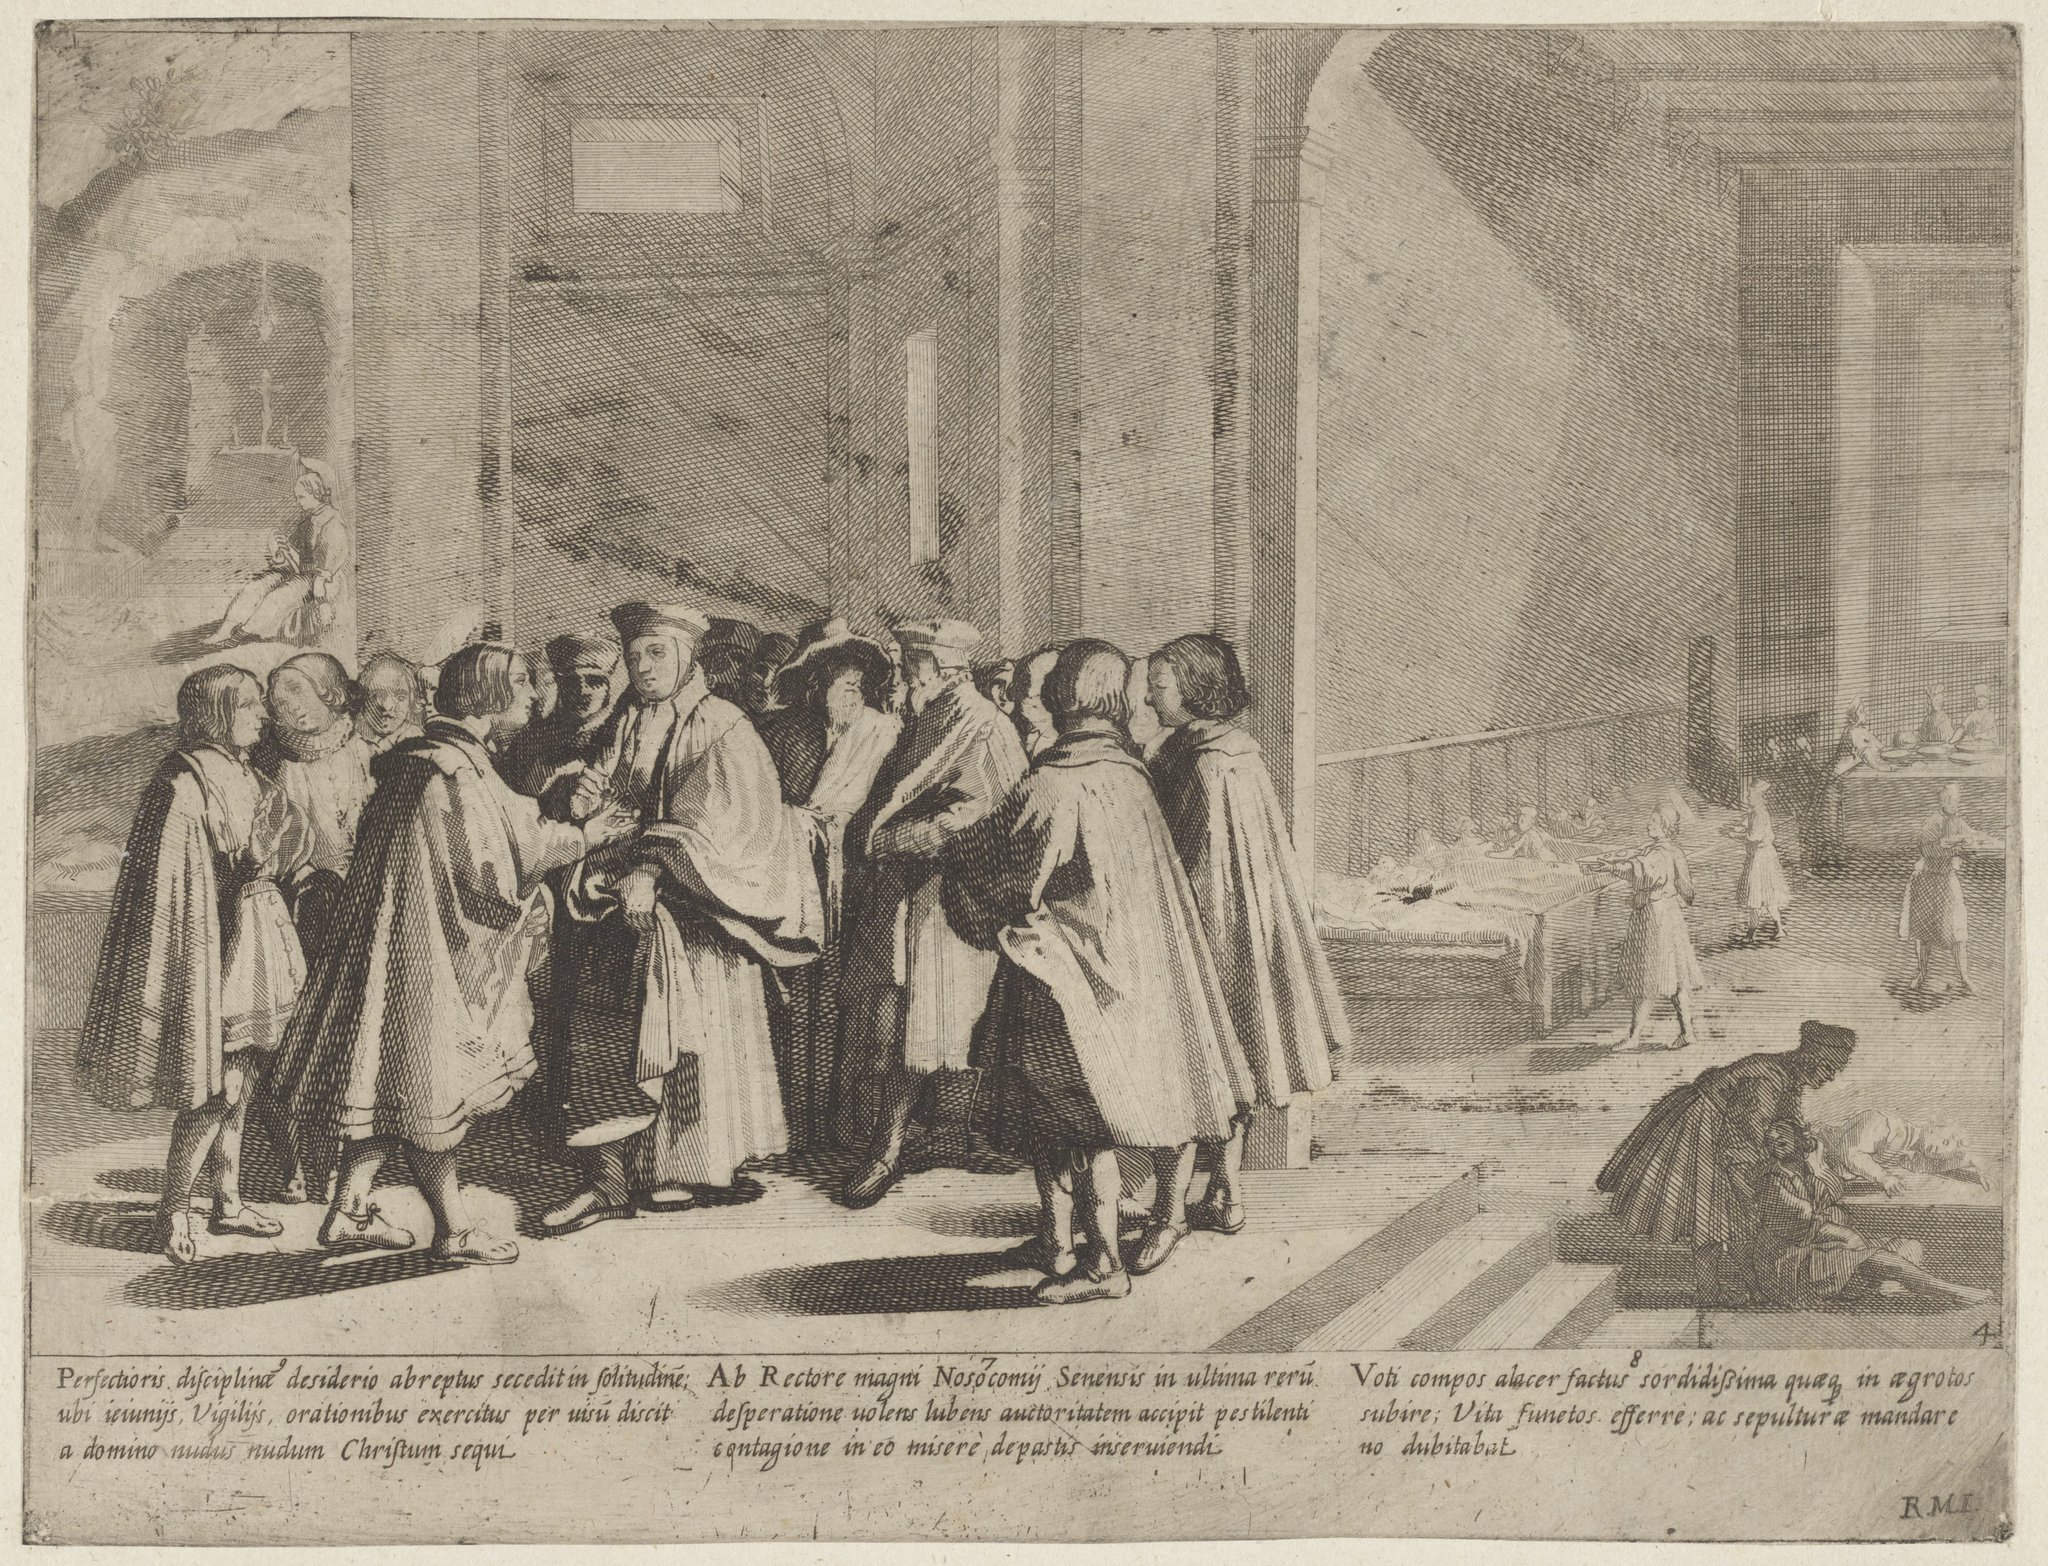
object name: print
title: Drie episoden uit het leven van de heilige Bernardinus van Siena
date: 1635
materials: paper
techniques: etching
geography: italy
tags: bernardino of siena, franciscan friar; possible attributes: book, tablet (disk) with ihs monogram, three mitres at his feet - early life of male saint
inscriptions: collector's mark: Lugt 2760, collector's mark: Lugt 2228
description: Op de voorgrond de doktoren van de hospitaals in Siena die zich in wanhoop wenden tot de rector tijdens de uitbraak van een pestepidemie (episode 7). Rechts de ziekenzaal van het hospitaal met pestlijders (episode 8). Op de achtergrond links de heilige Bernardinus van Siena wakend en mediterend voor een altaar (episode 9).